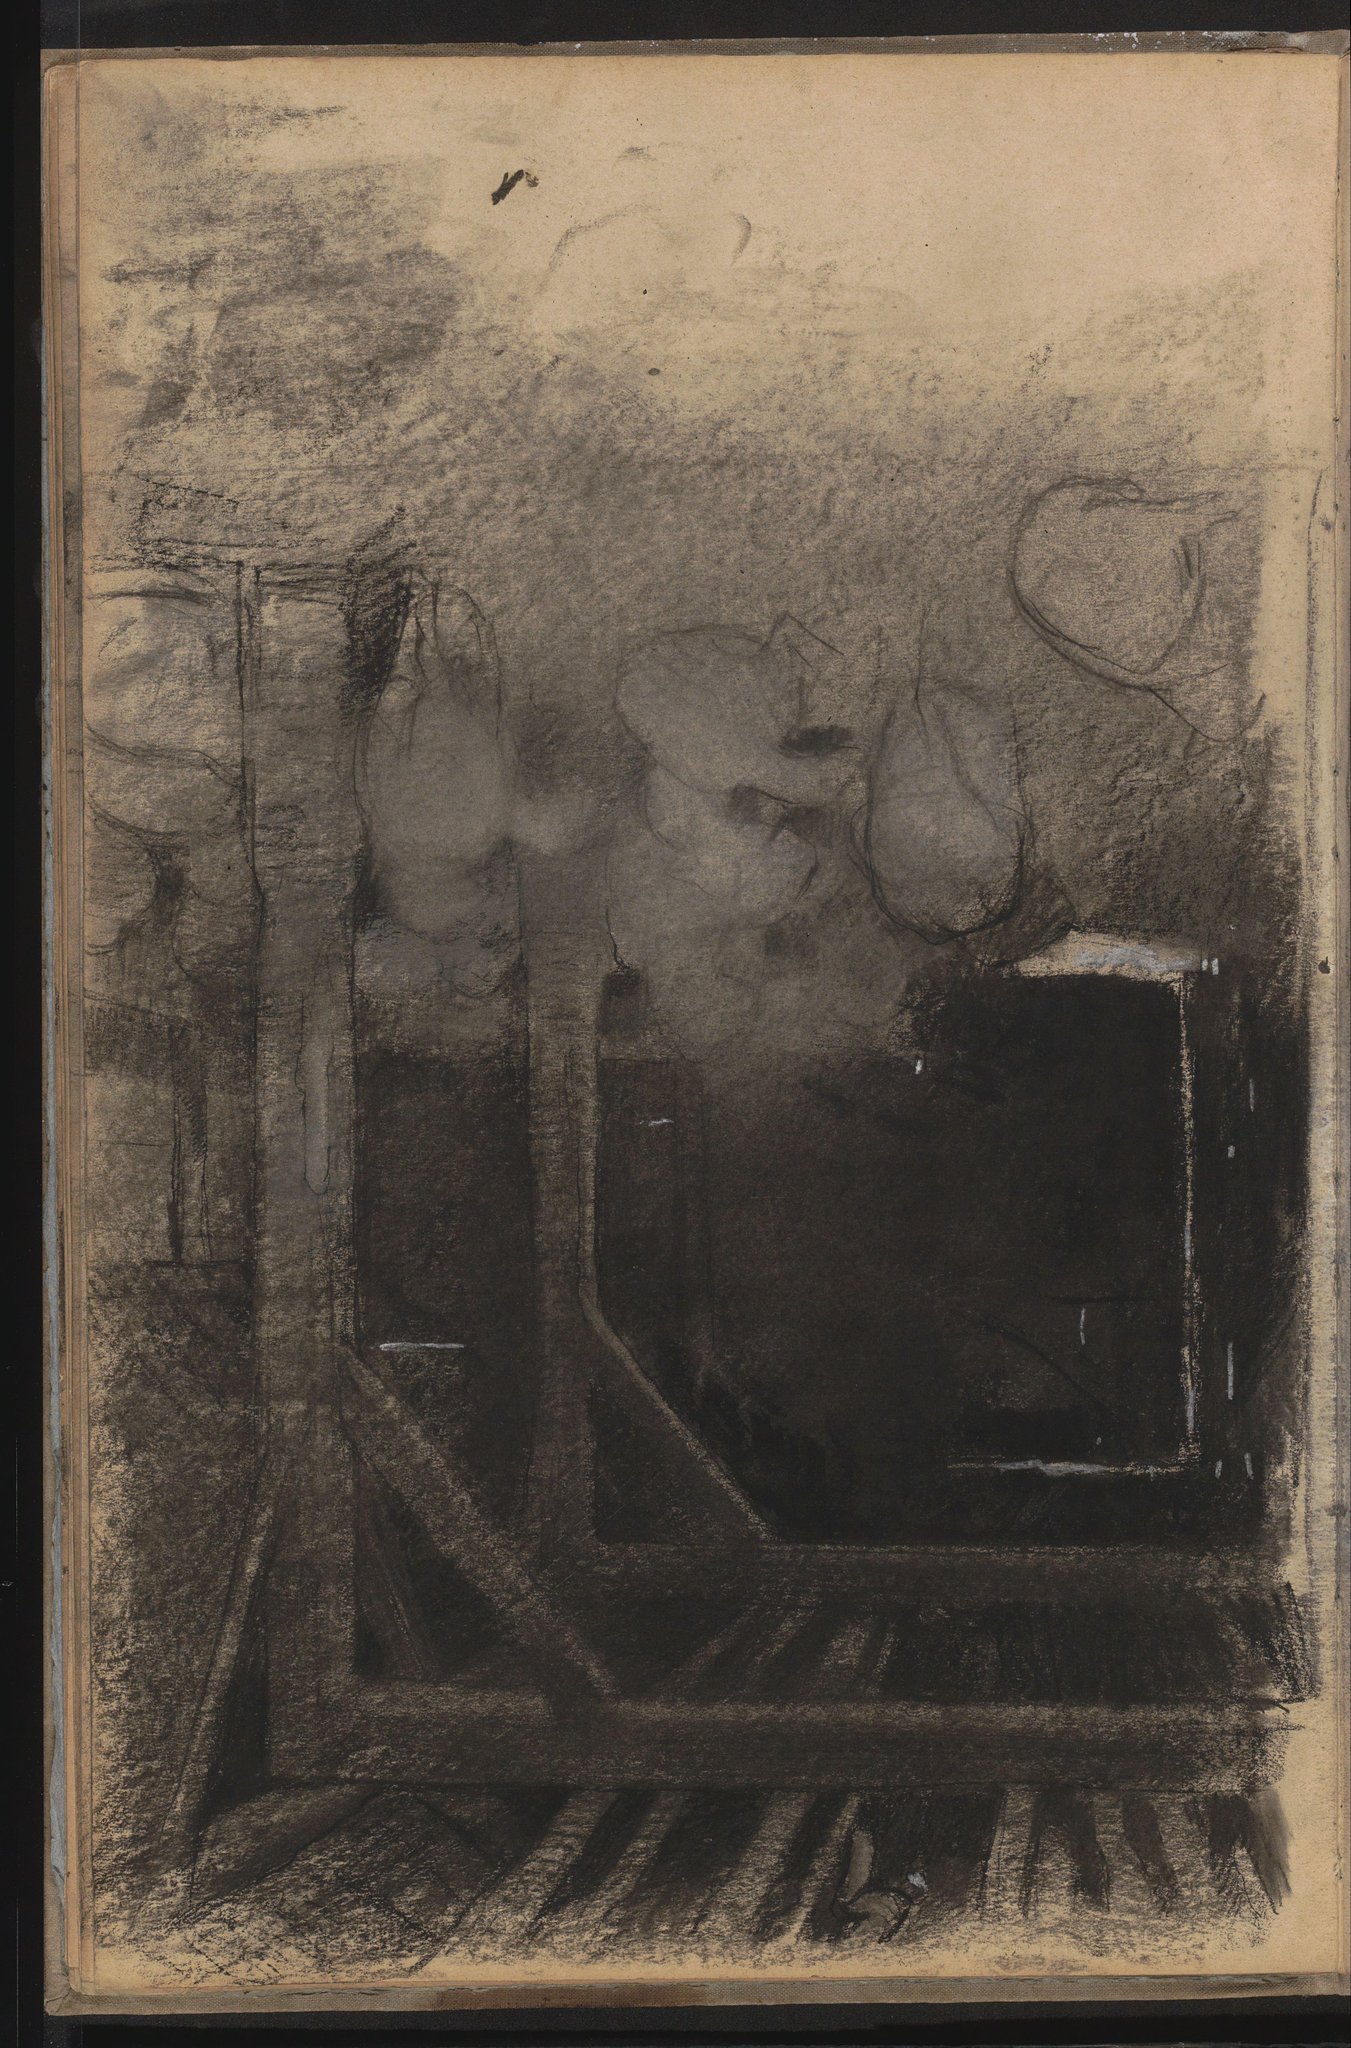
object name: sketchbook leaf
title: Interieur van een schaapskooi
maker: willem witsen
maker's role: draughtsman, painter, print maker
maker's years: 1860-1923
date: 1884-1887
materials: chalk, paper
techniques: stumping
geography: ewijkshoeve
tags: sheep, stall, stable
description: Pagina 52 uit een schetsboek met 45 bladen vervaardigd rond de Ewijkshoeve.